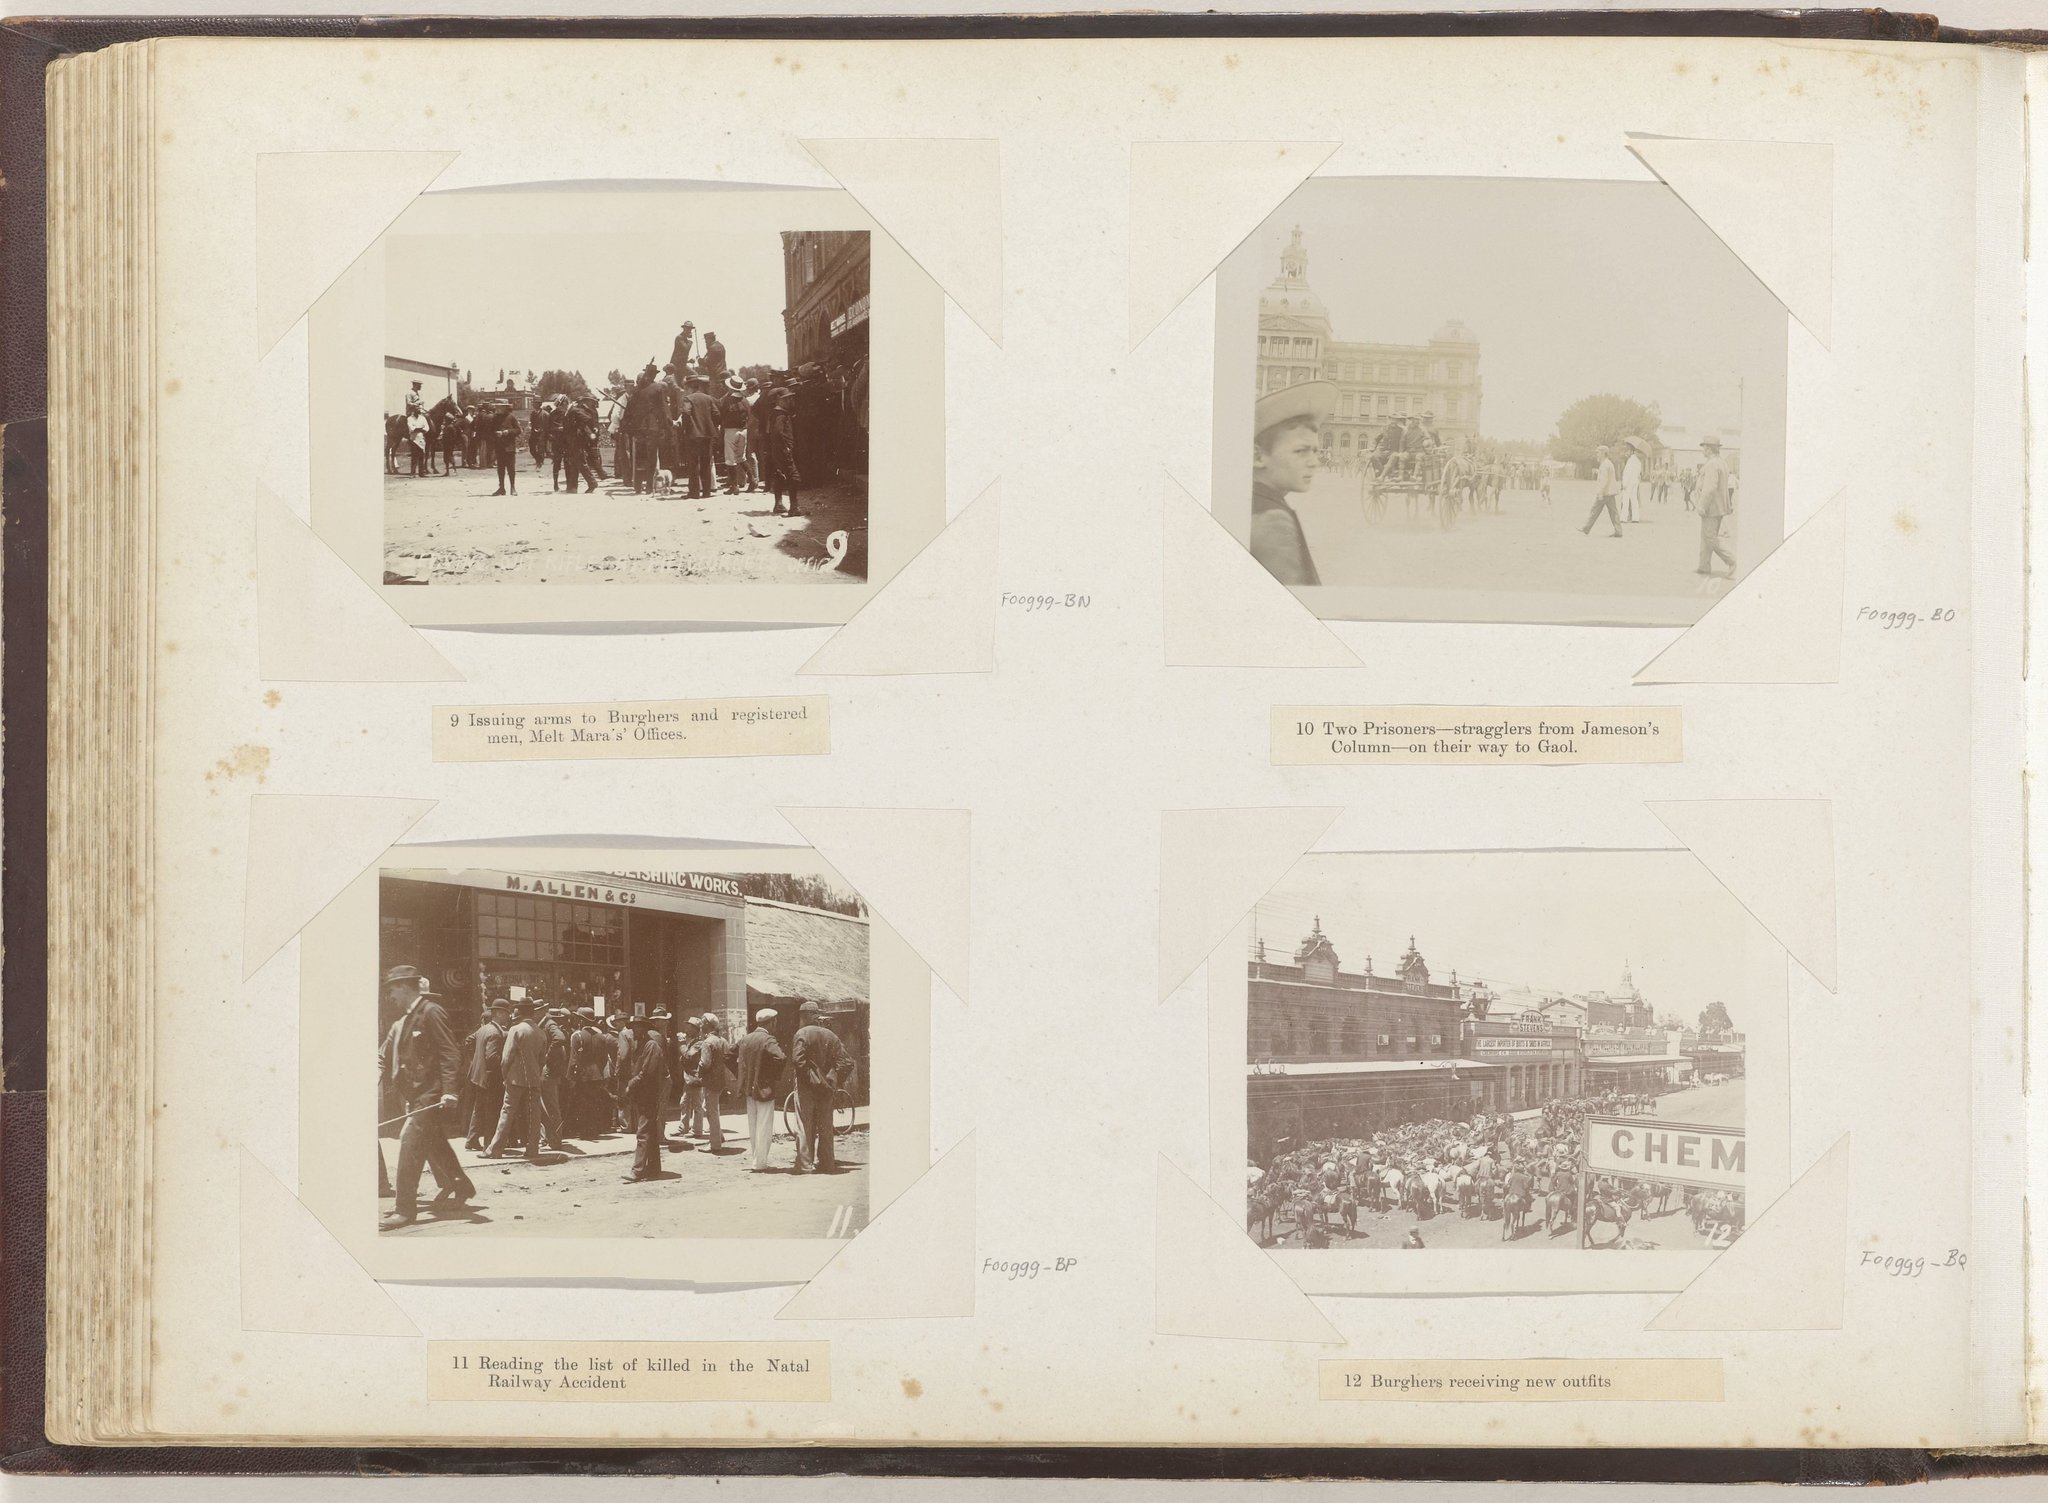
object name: photograph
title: Burgers bekijken de slachtofferlijst van een treinongeluk in Natal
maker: Anonymous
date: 1896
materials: paper, photographic support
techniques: gelatin silver print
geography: south africa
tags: street (+ city(-scape) with figures, staffage)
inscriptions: number: ‘11’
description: Onderdeel van Album met 191 foto's van een reis naar en door Zuid-Afrika.